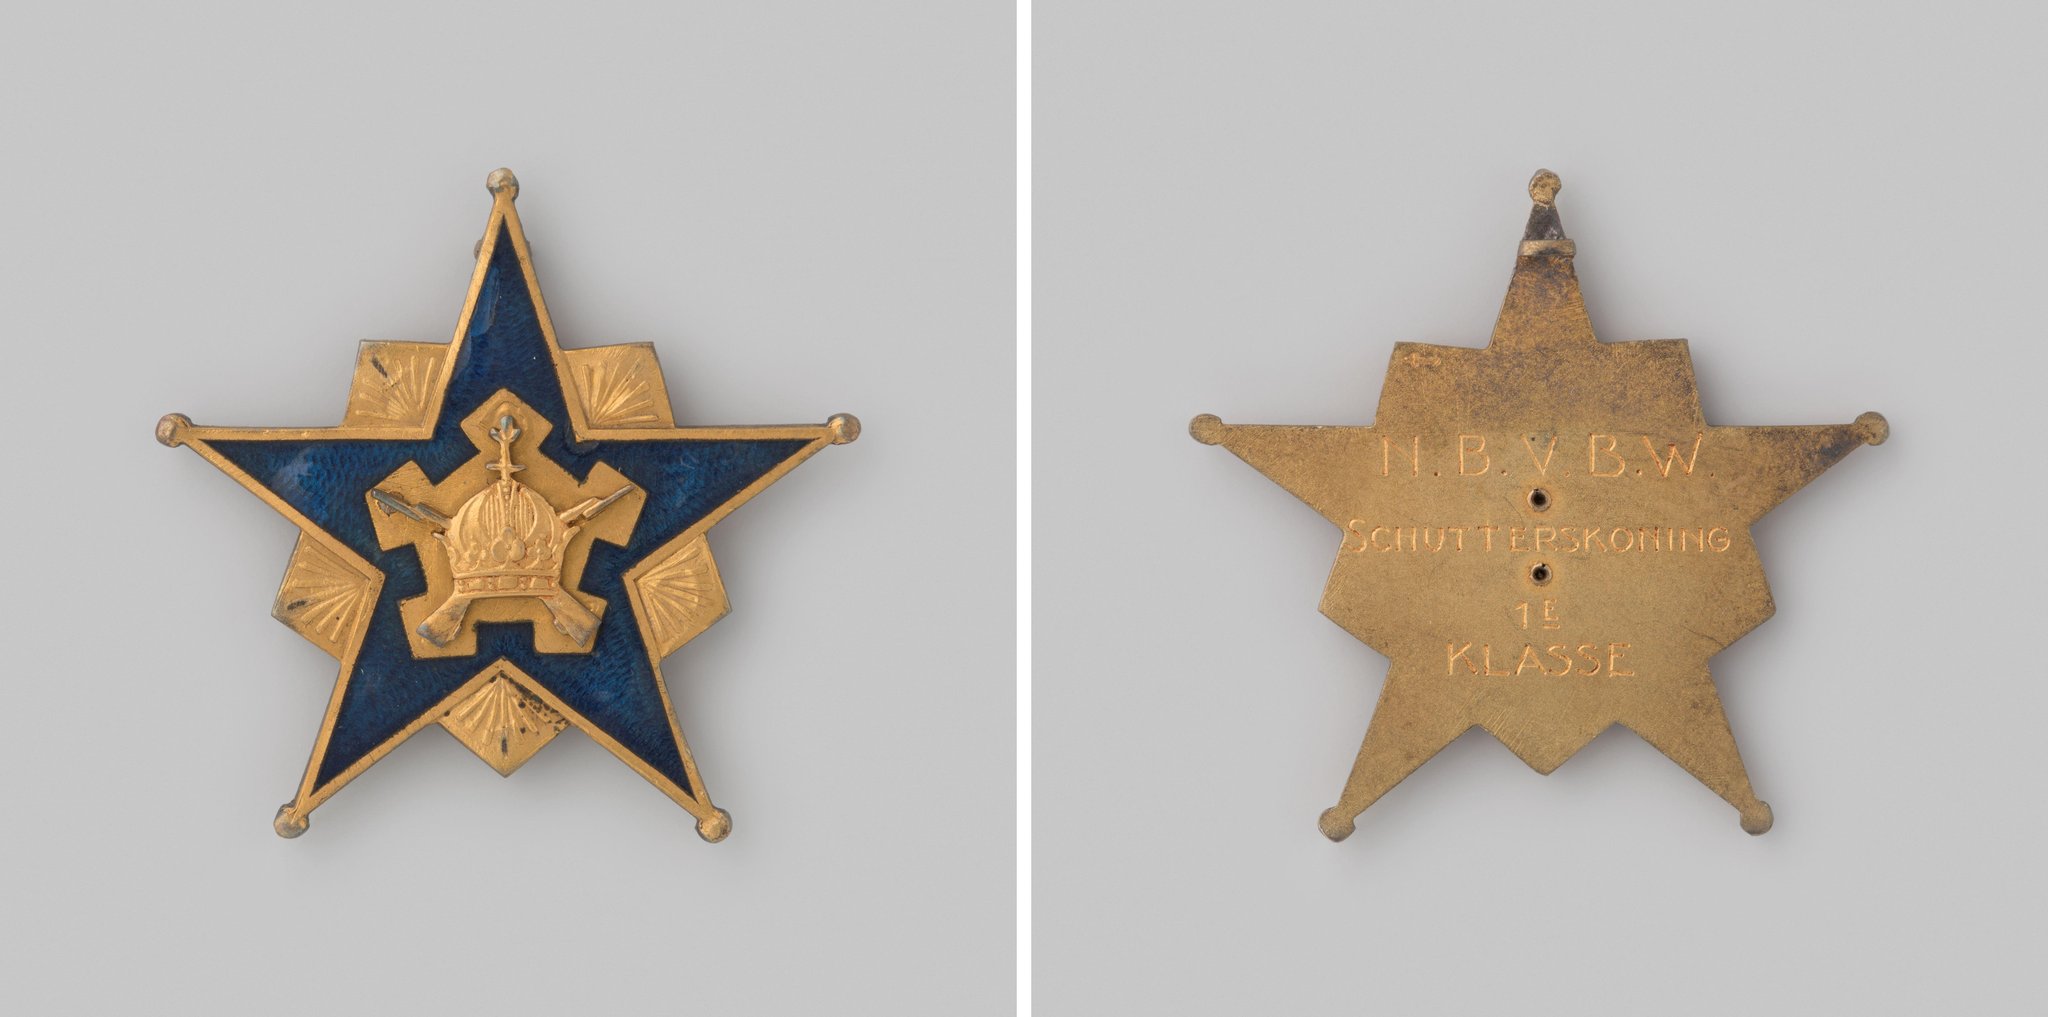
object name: medal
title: Kruis voor Schutterskoning van de Nederlandse Bond van Vrijwillige Burgerwachten, 1e klasse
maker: Anonymous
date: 1922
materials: silver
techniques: gilding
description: Verguld zilveren draagpenning met oog en ring. Het Kruis voor Schutterskoning is een 38 millimeter brede, blauw geëmailleerde, vijfpuntige ster, geplaatst over een vijfhoek bestaande uit stralen. In het midden van de ster is een bastion geplaatst, waarover een kroon boven twee gekruiste geweren. De keerzijde is vlak met gravering: N.B.V.B.W. / SCHUTTERSKONING / 1E / KLASSE.